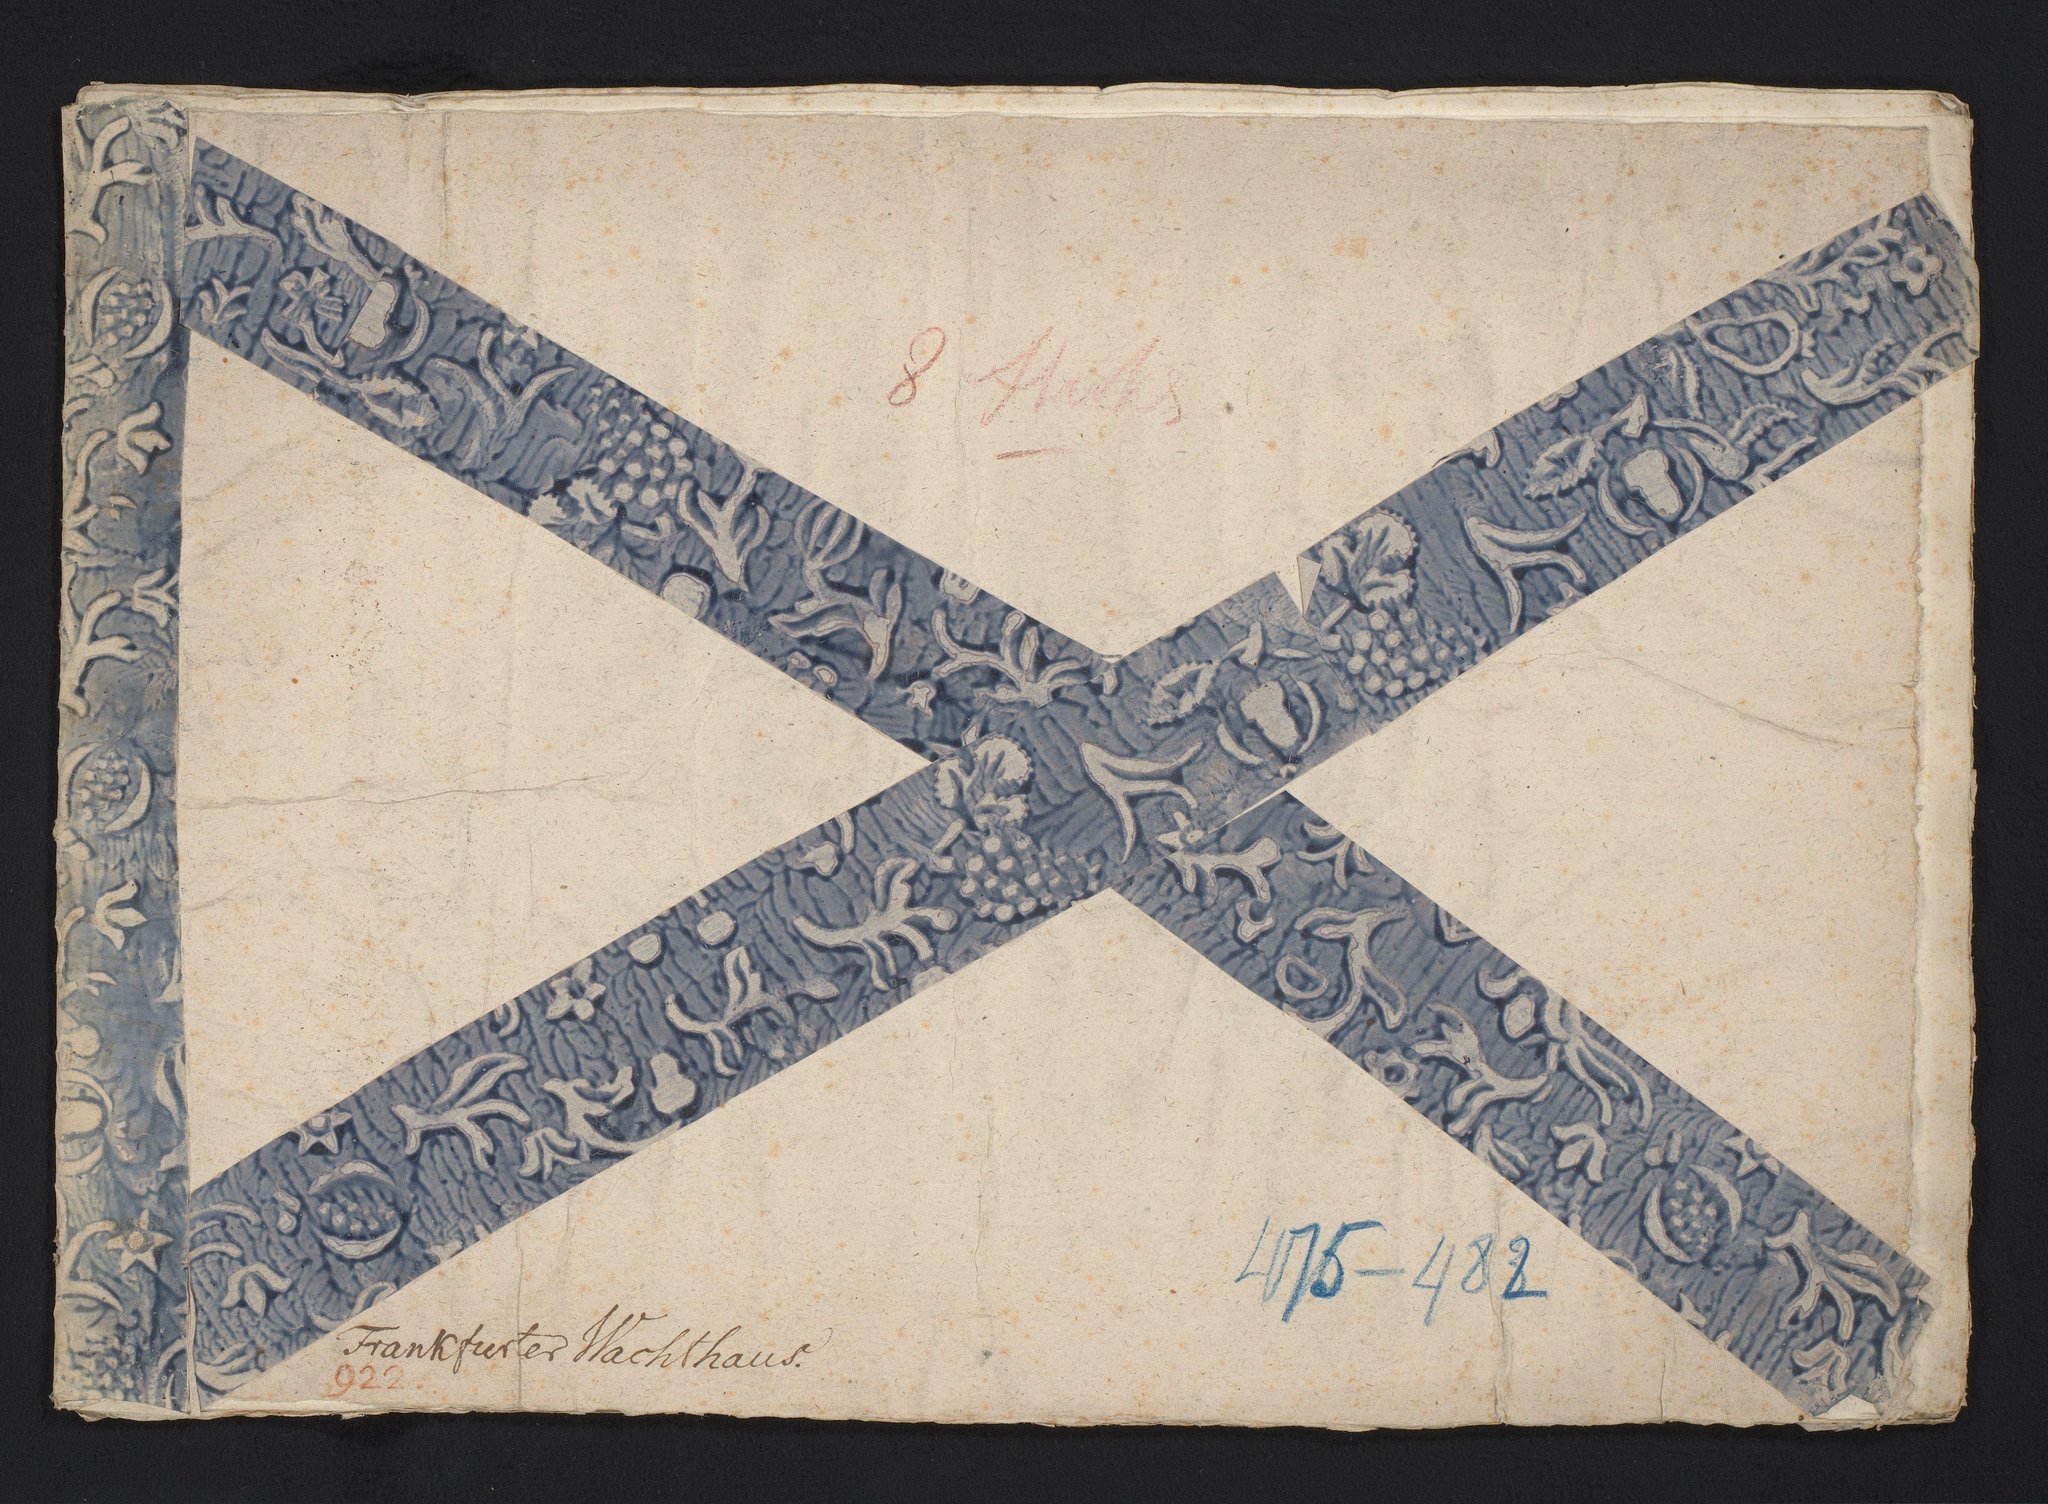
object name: wrapper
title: Frankfurter Wachthaus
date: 1729-1730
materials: ink, paper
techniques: pen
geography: frankfurt am main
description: Omslag met sierpapier van serie van acht prenten.